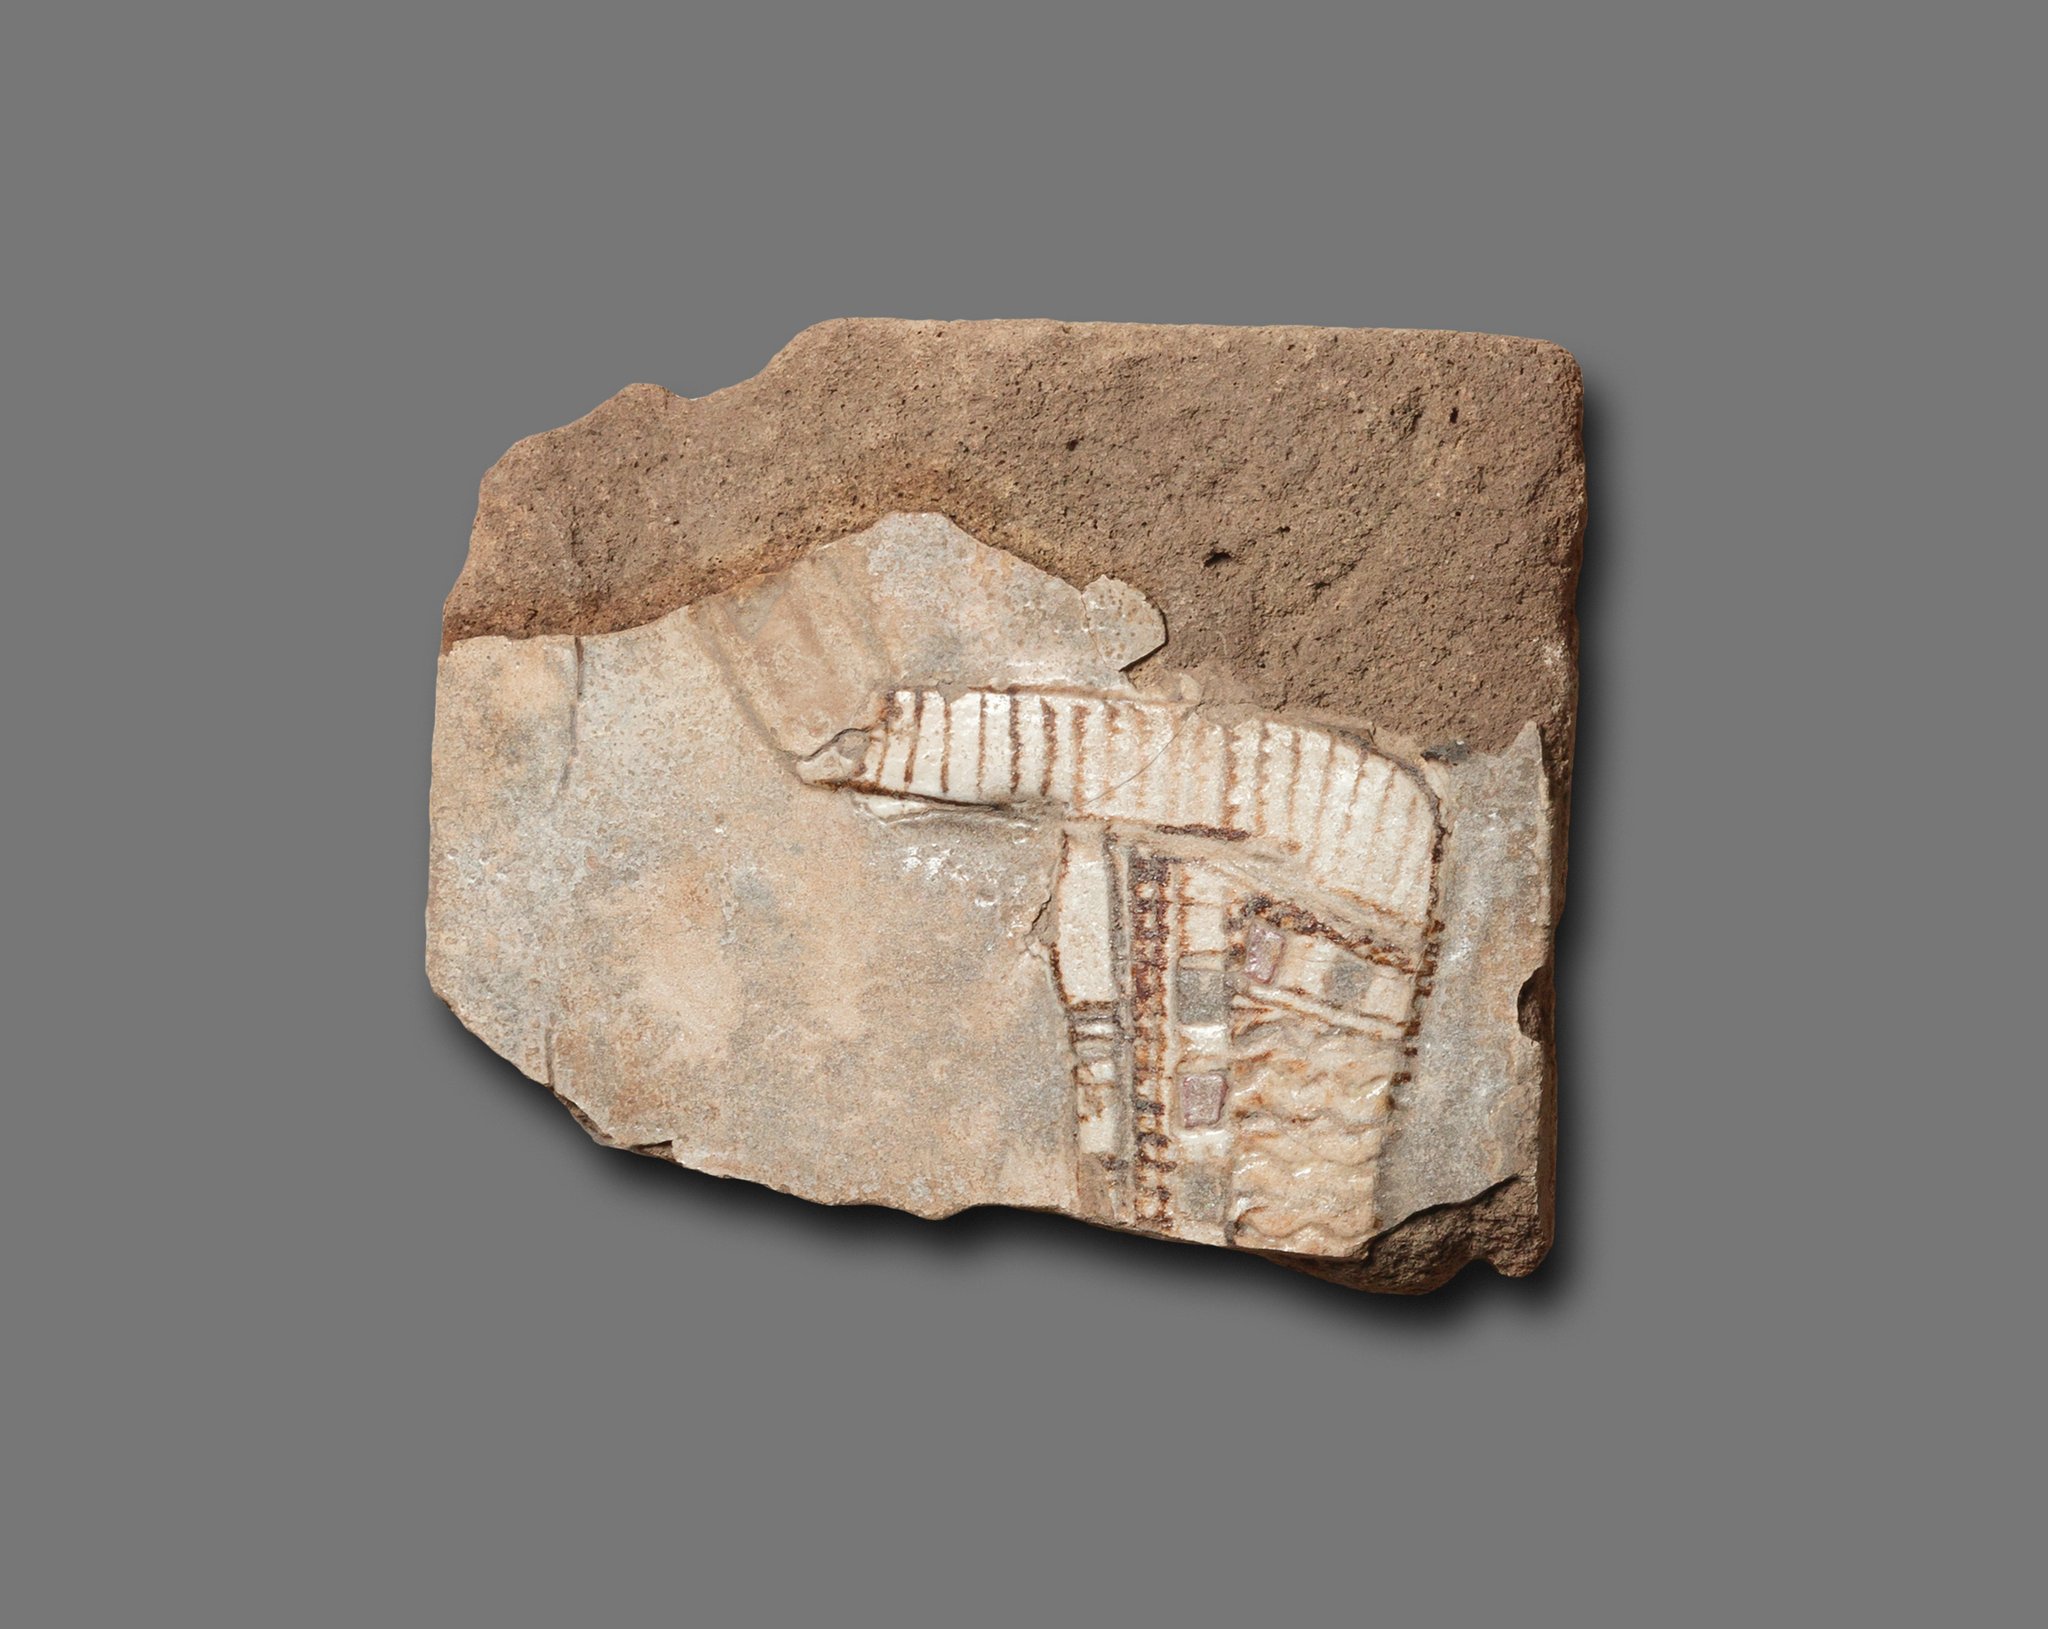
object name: tile inlay, palace of ramesses ii, foreigner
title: Tile depicting Foreigners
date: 1279-1213 BCE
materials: faience, paste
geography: egypt